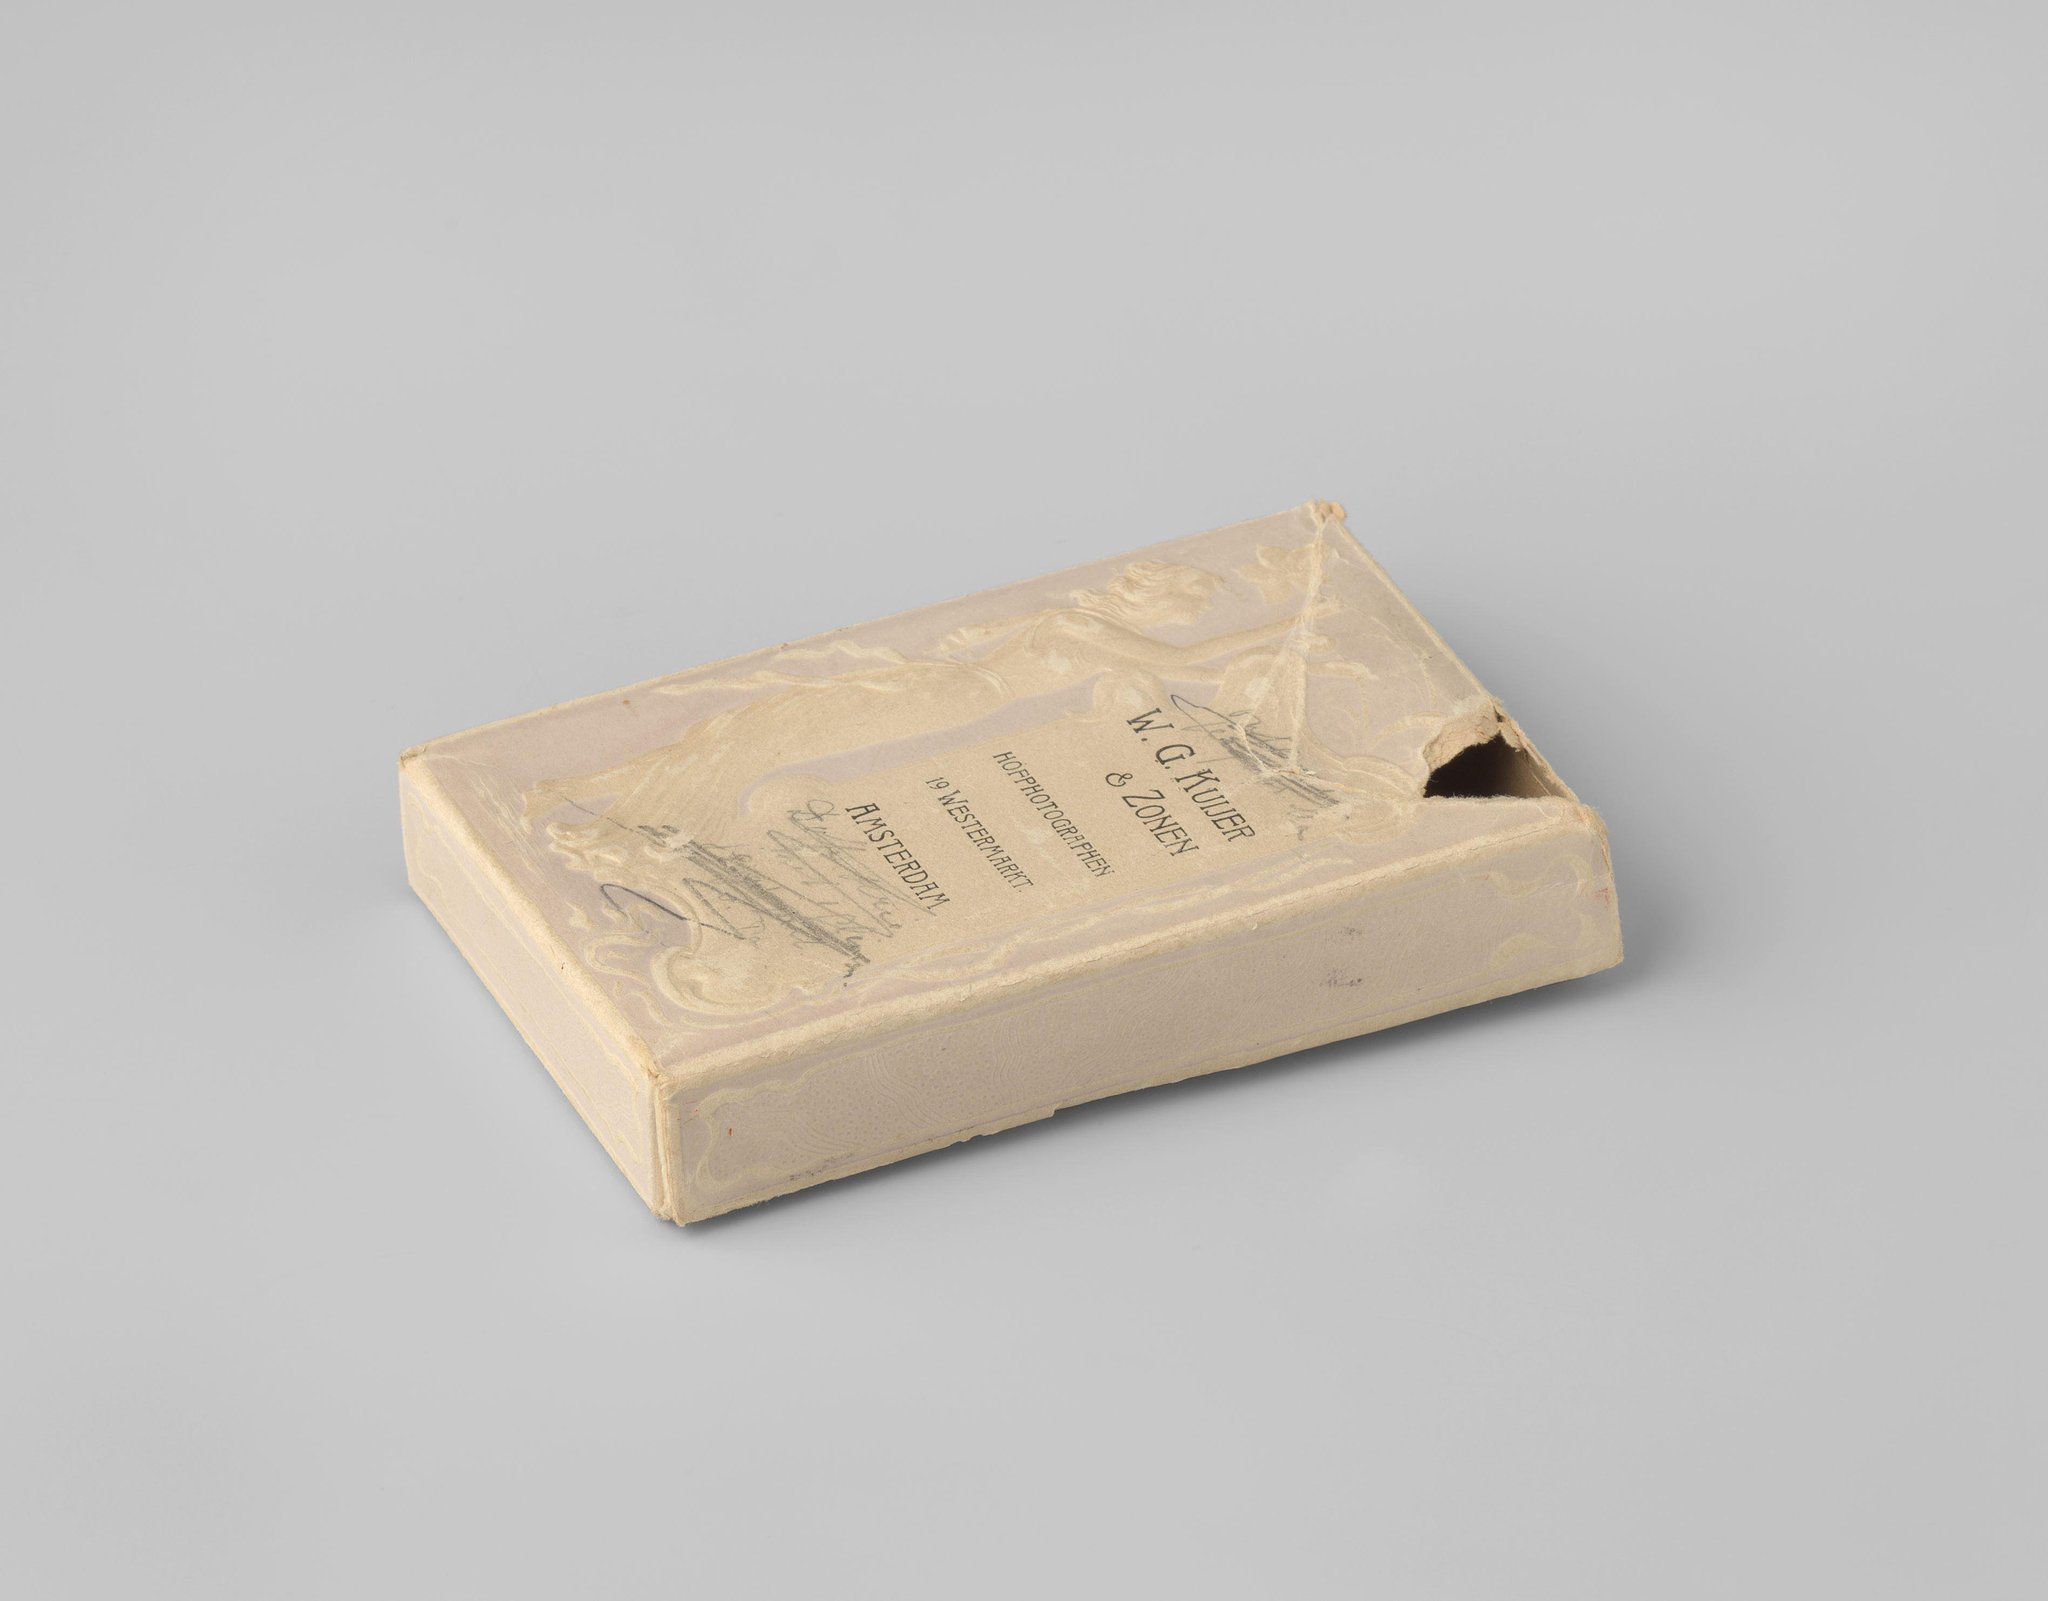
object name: box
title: Doos voor foto's van fotograaf W.G. Kuijer & Zonen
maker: Anonymous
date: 1884-1906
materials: cardboard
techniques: blind stamped, letterpress printing, lithograph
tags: flowers, adolescent, young woman, maiden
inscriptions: inscription: ‘W.G. Kuijer/ & Zonen/ Hofphotographen/ 19 Westermarkt./ Amsterdam’, inscription: ‘ont[...]/ [...] serie [...]’